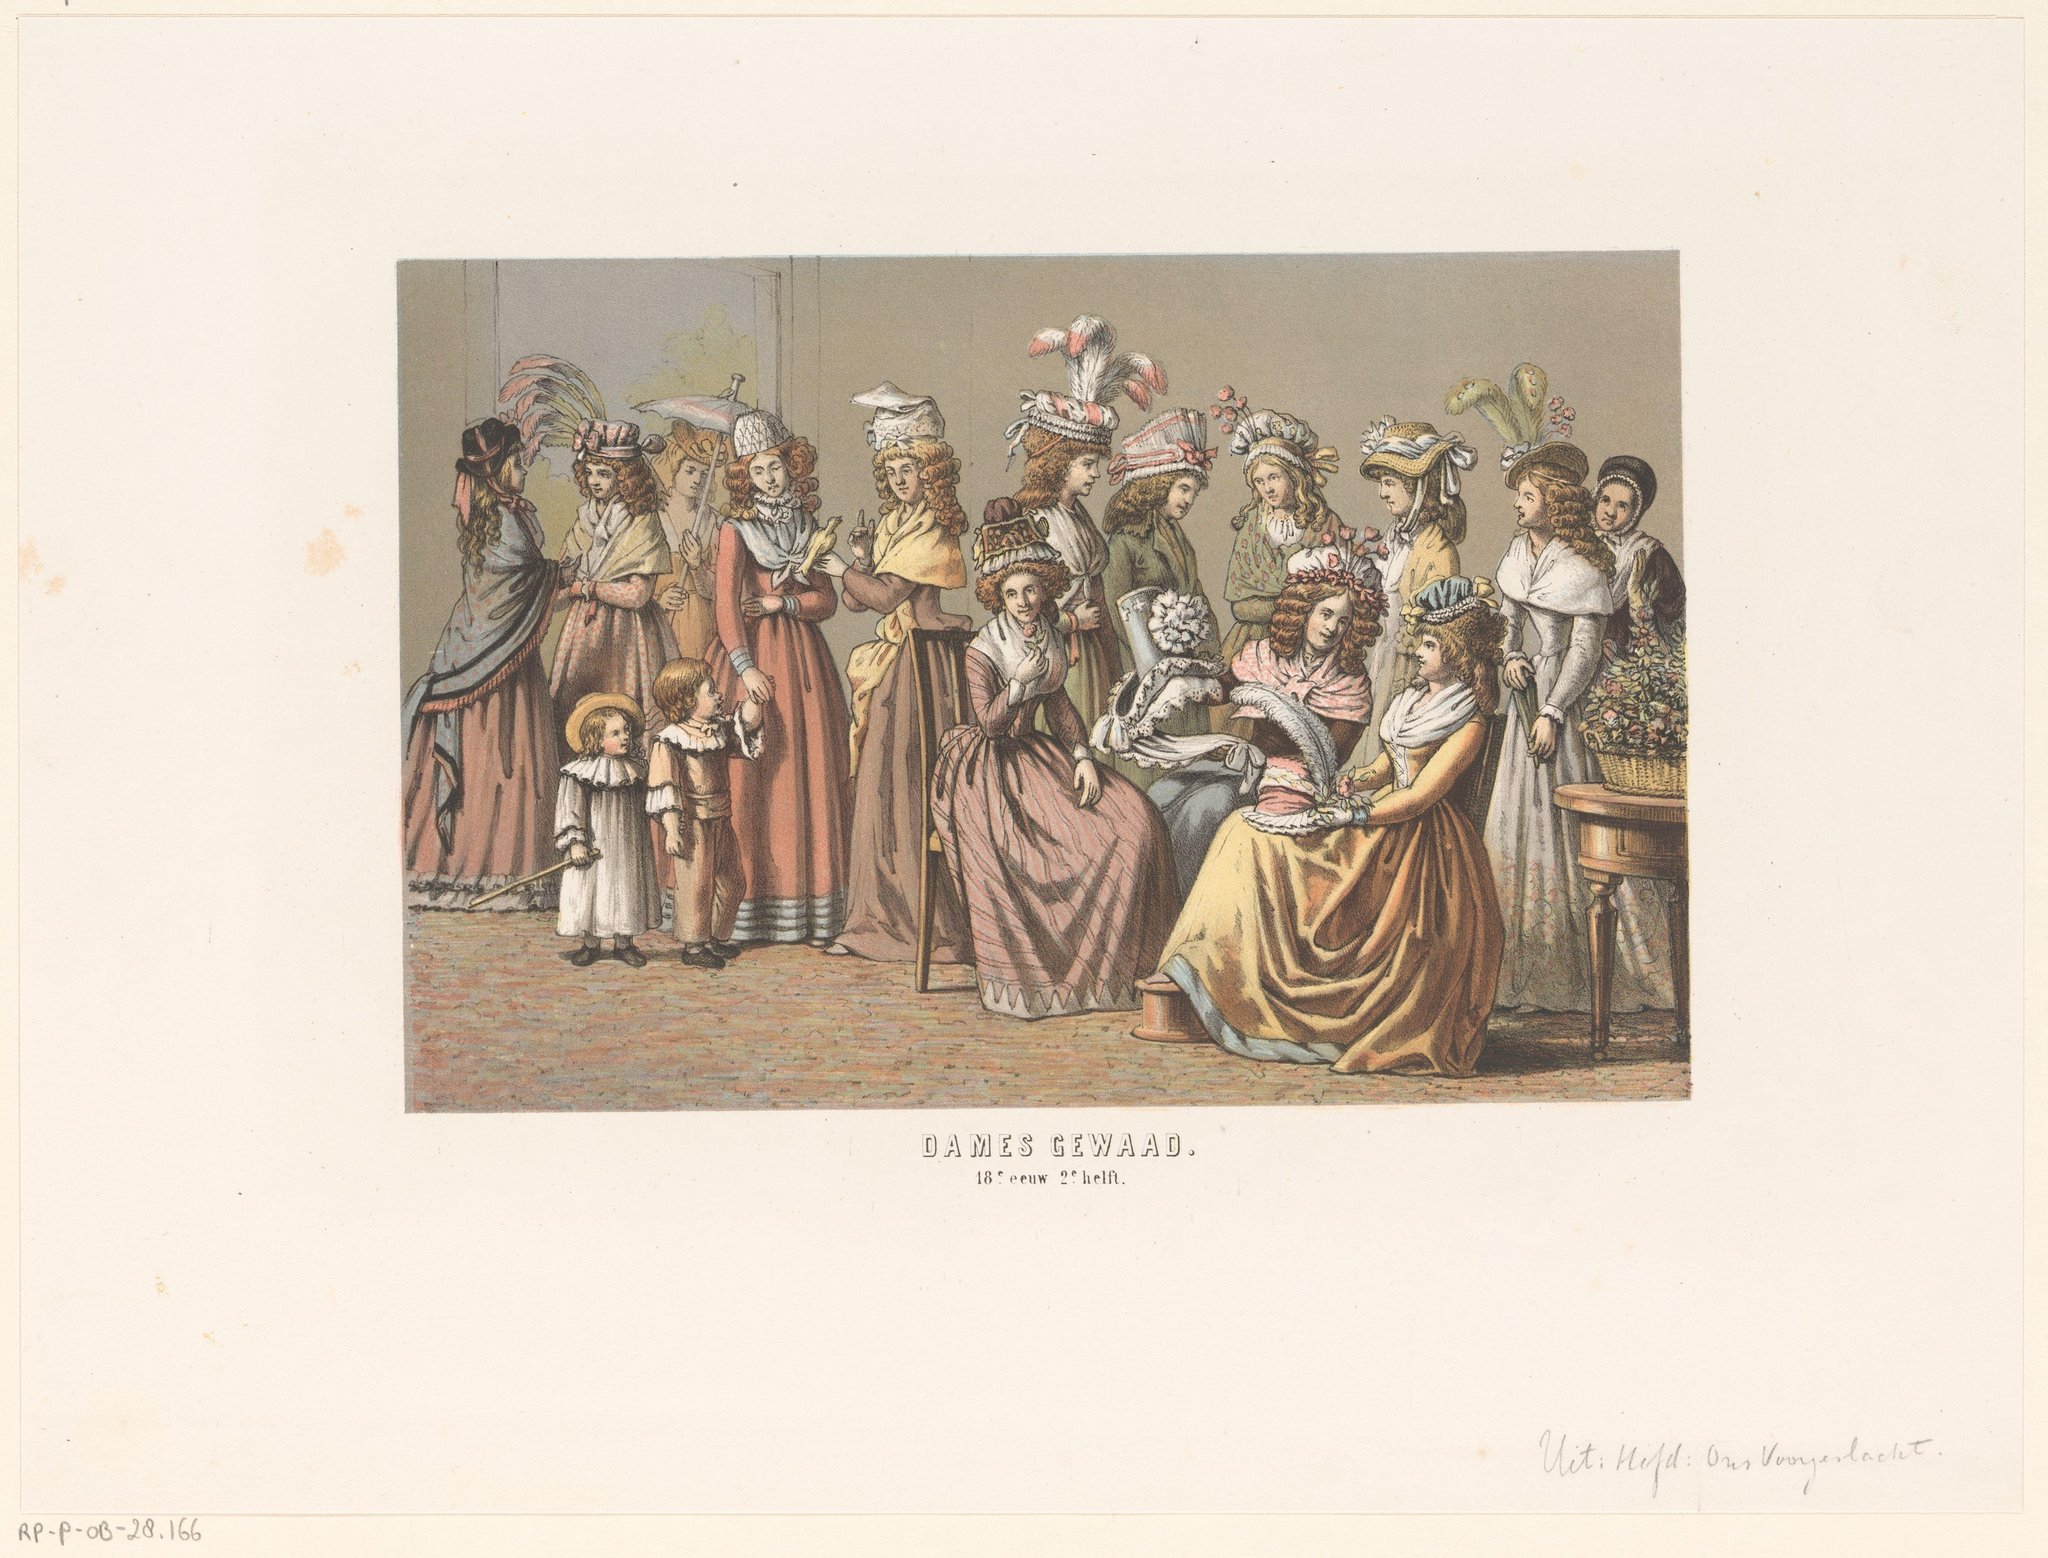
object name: print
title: Dameskleding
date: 1857-1864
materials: paper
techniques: lithograph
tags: fashion, clothing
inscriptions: collector's mark: Lugt 2228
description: De dames dragen kleding uit de tweede helft van de achttiende eeuw. Zij staan en zitten in een interieur. Een vrouw heeft twee kinderen bij zich.